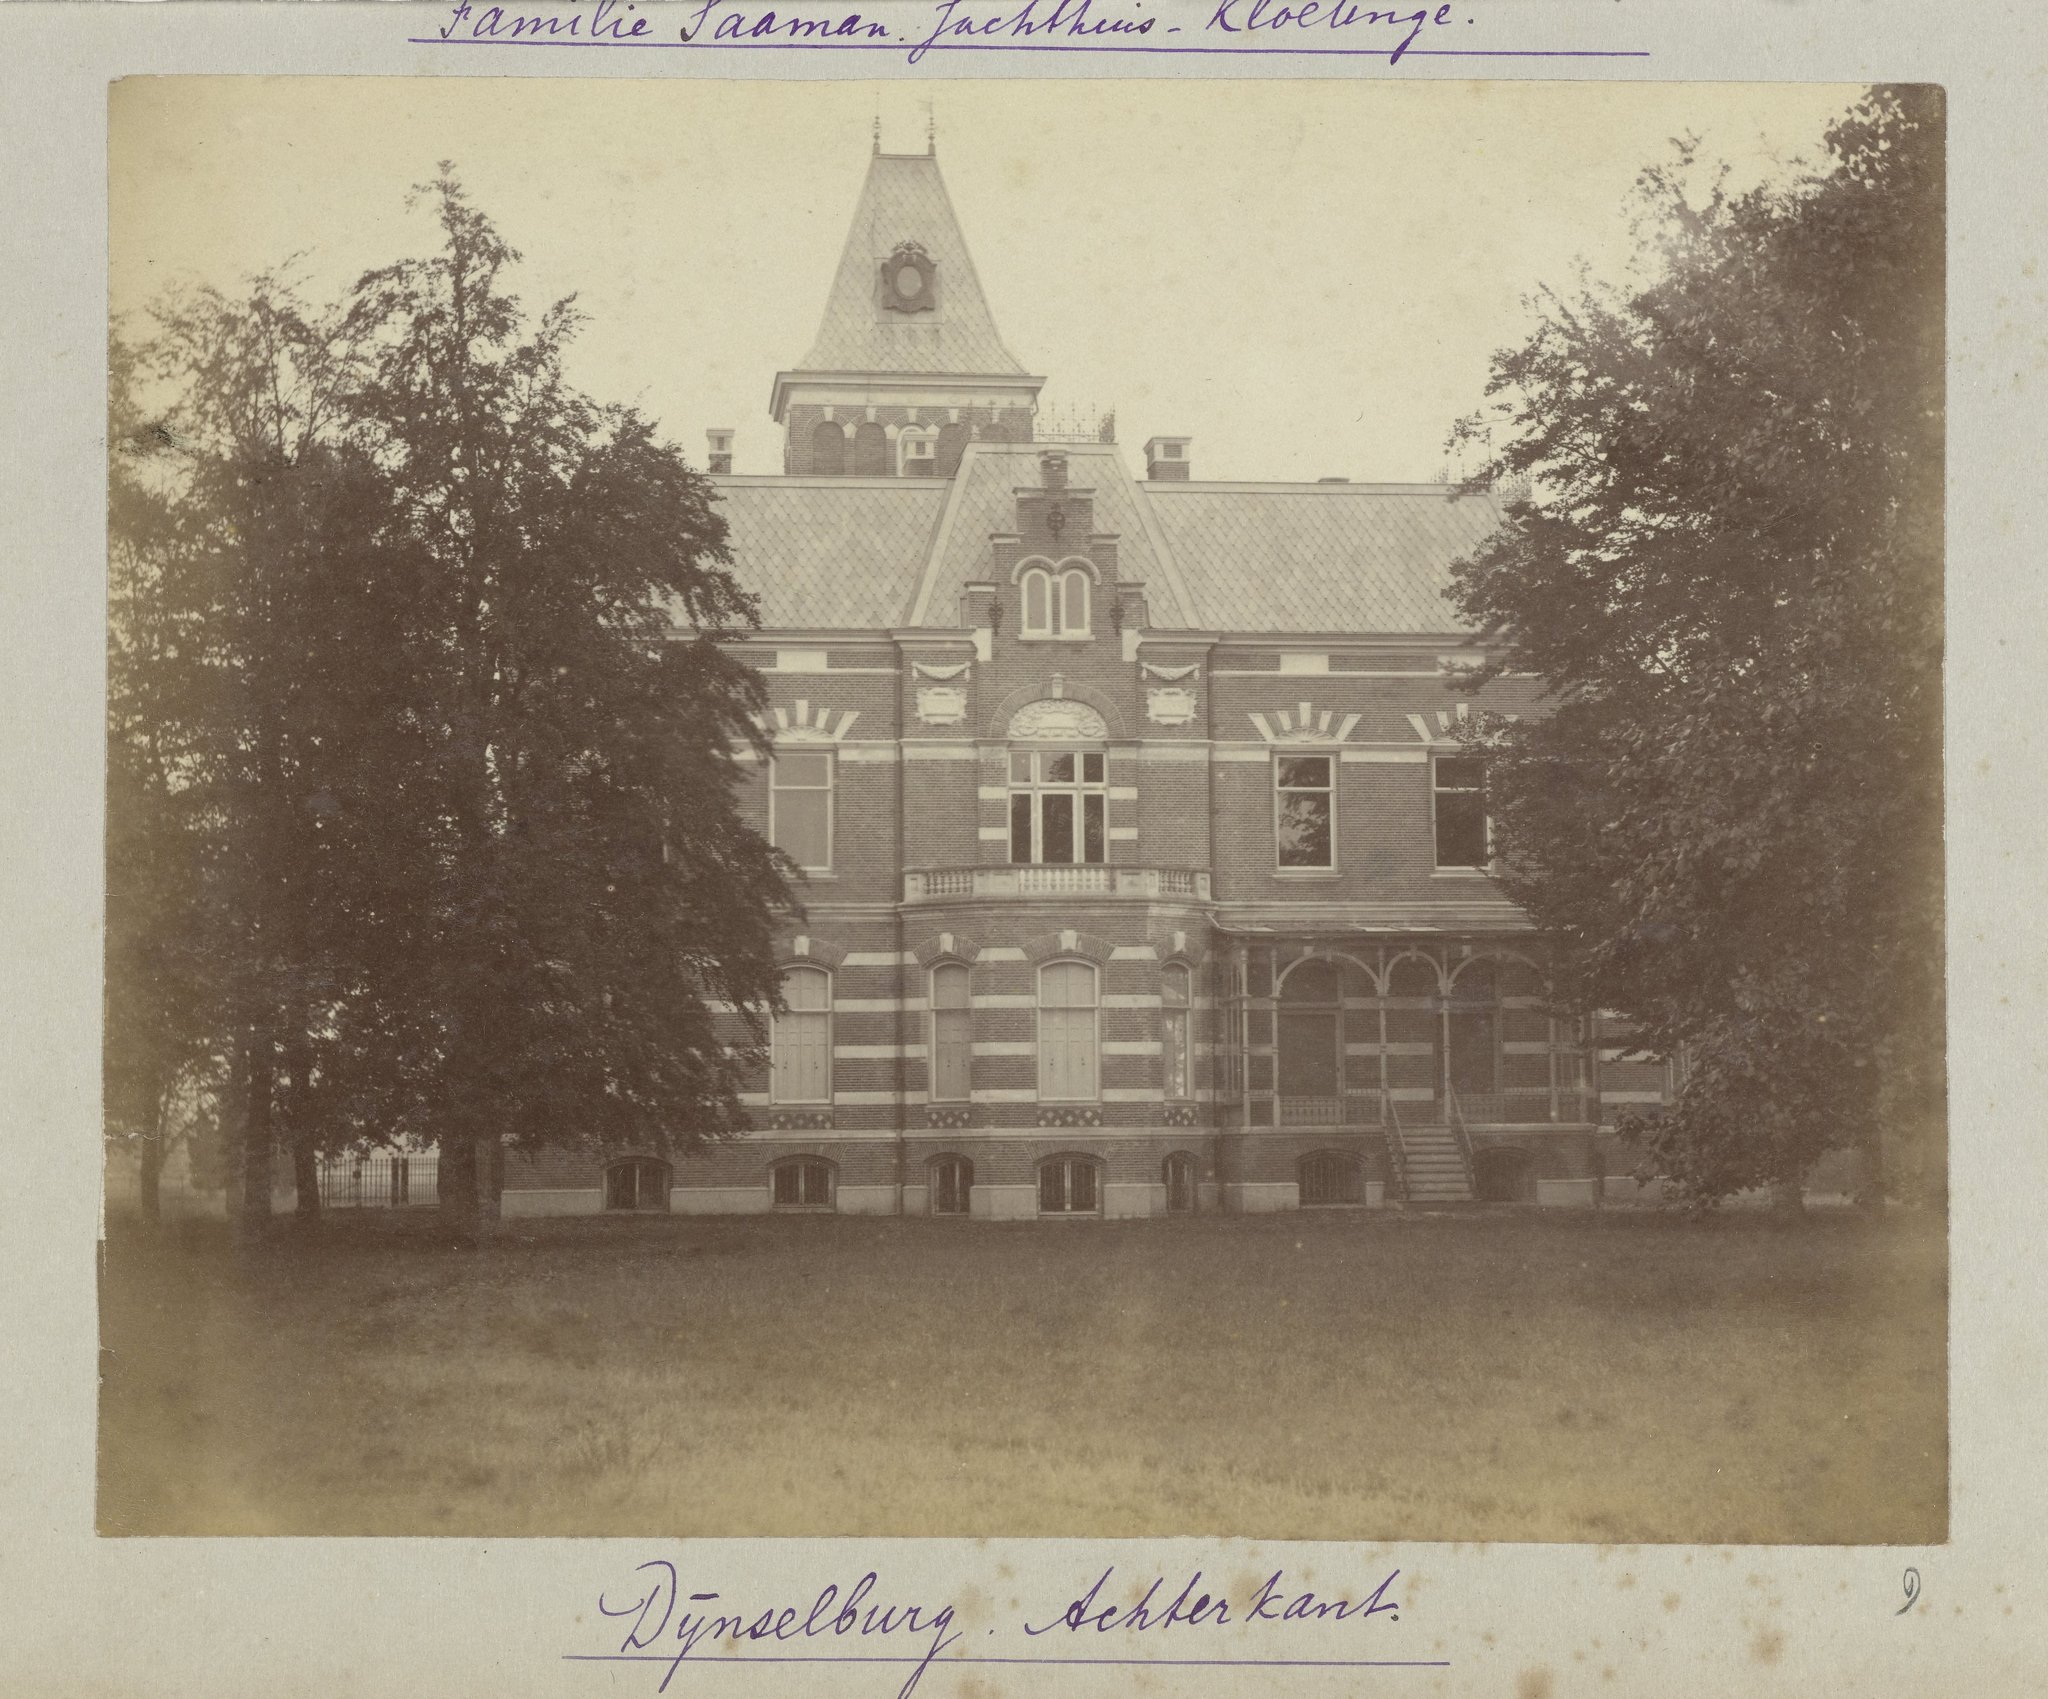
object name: photograph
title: Achterkant van landhuis Dijnselburg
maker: henry pauw van wieldrecht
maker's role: fotograaf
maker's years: 1863-1912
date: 1888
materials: paper, photographic support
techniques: albumen print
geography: netherlands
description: De achterkant van landhuis Dijnselburg. Met onderschrift: Dijnselburg, achterkant.